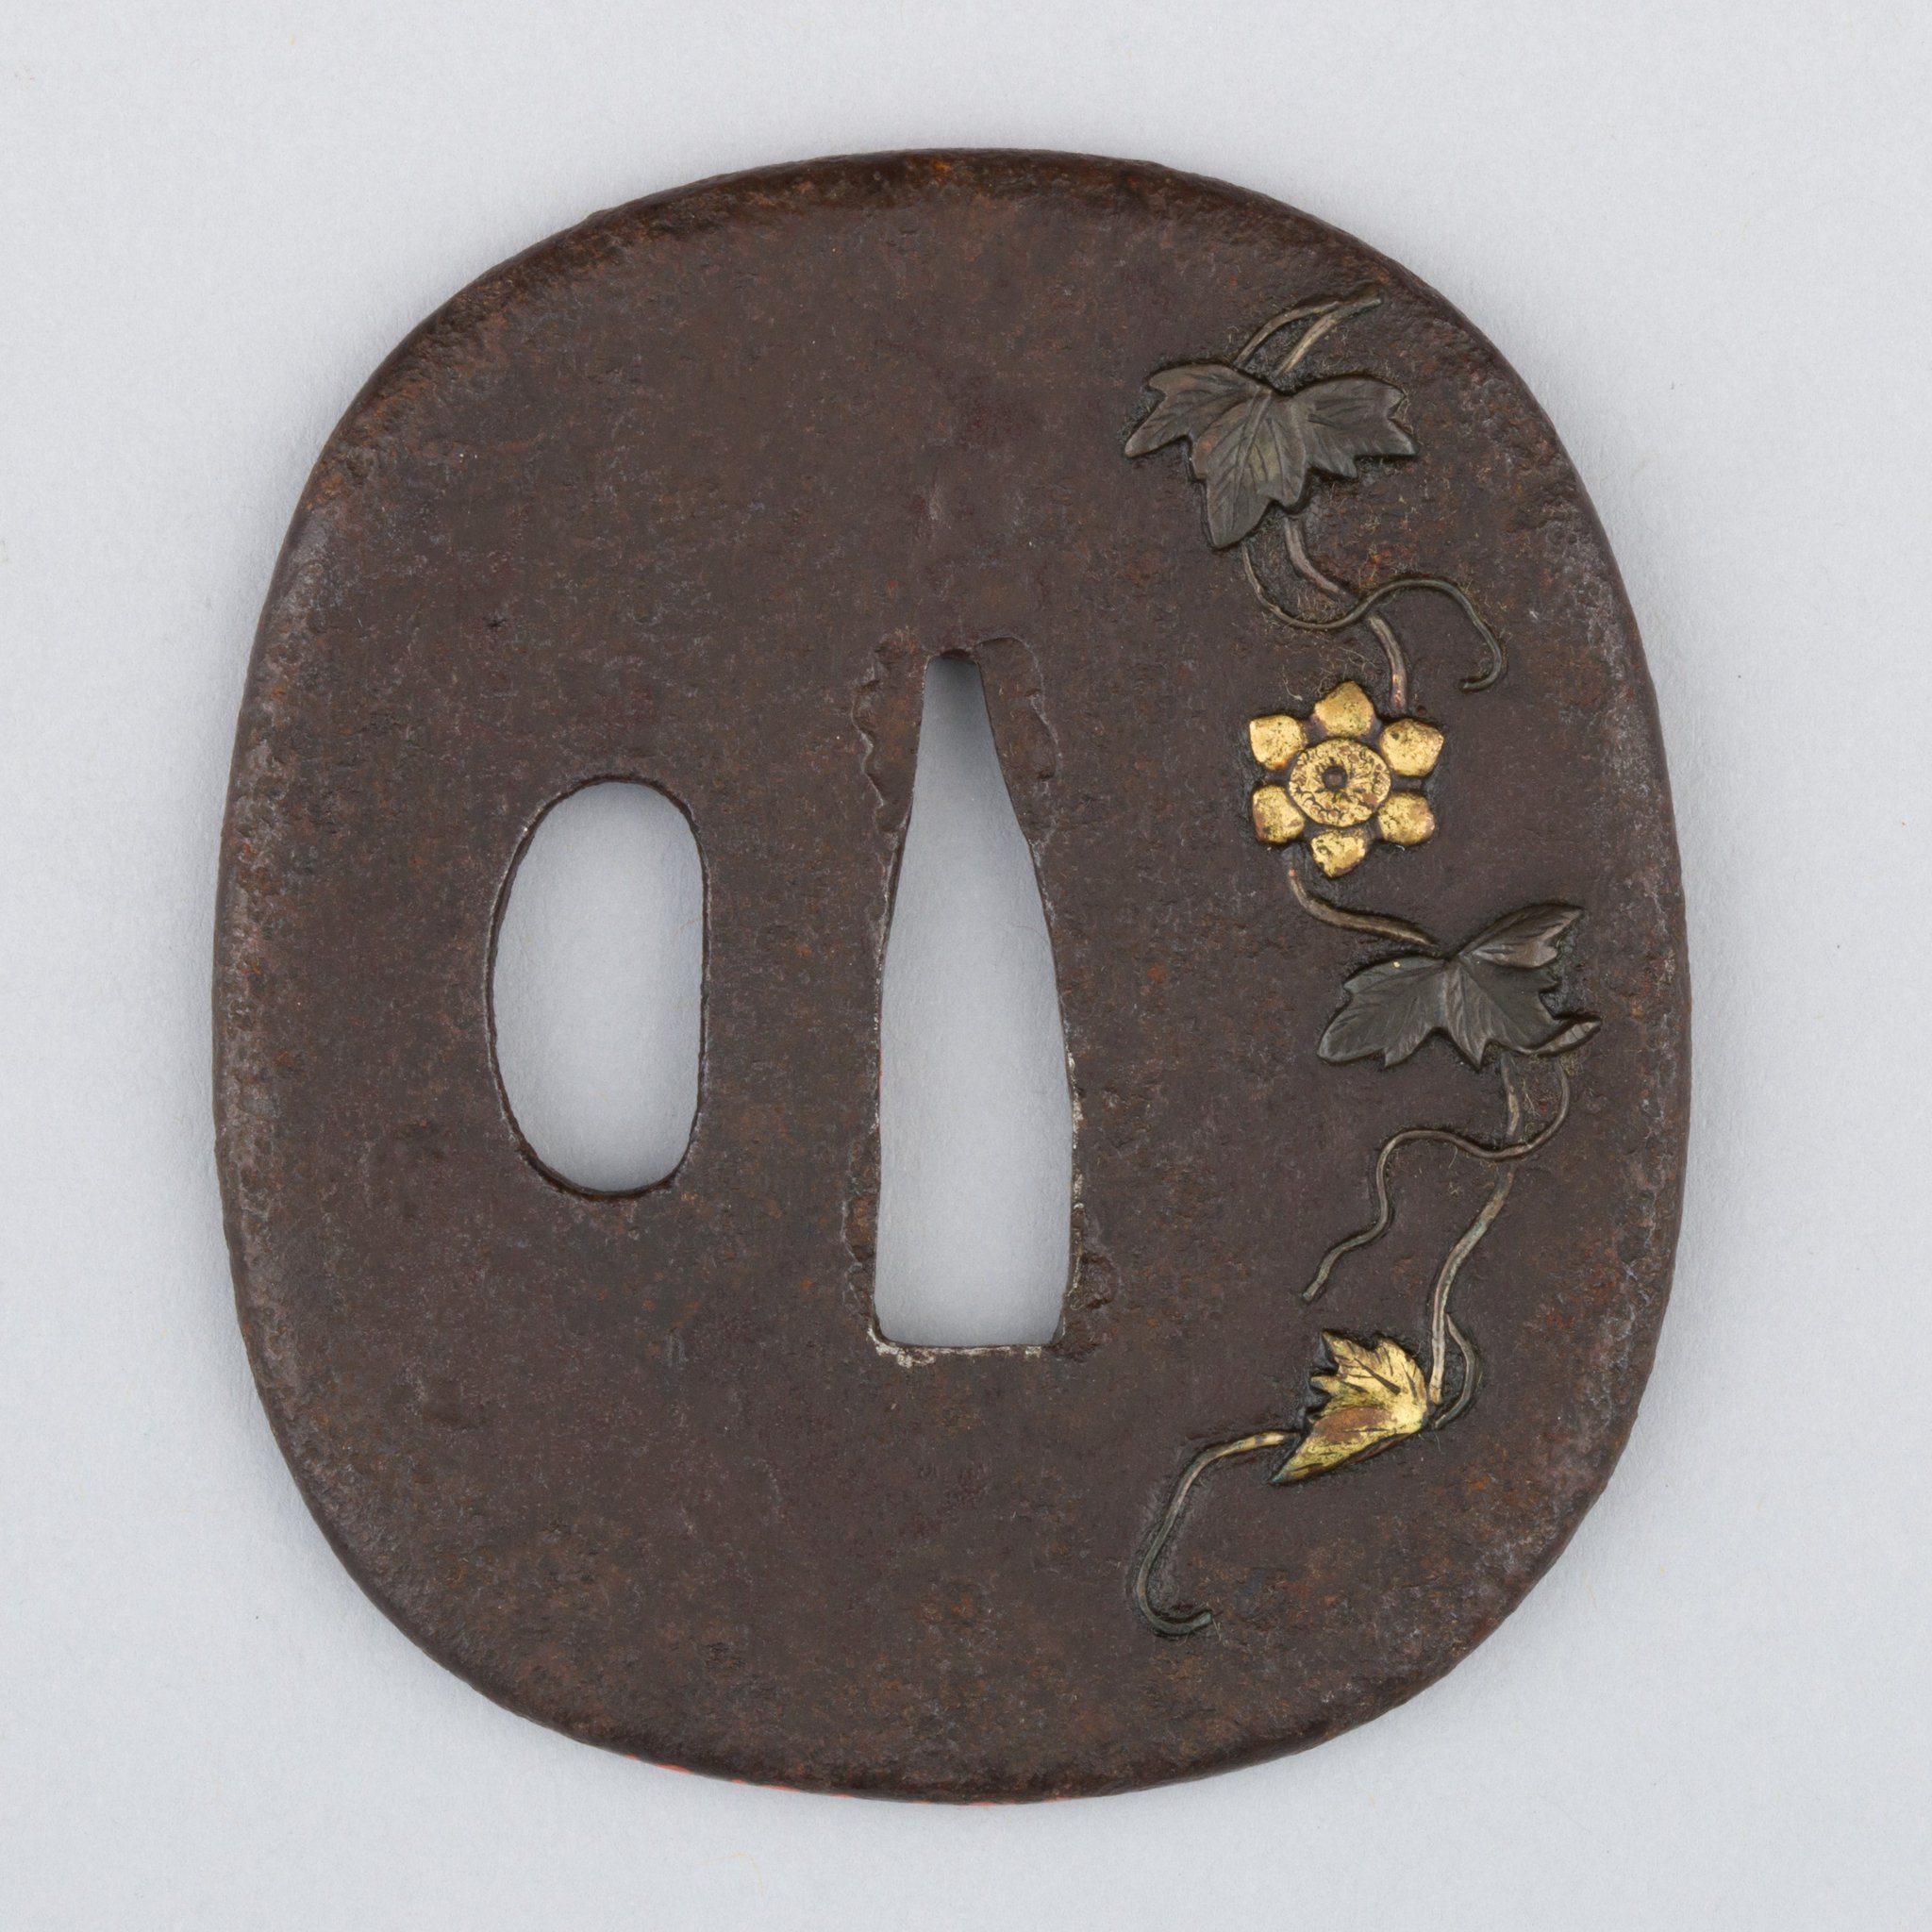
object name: sword guard tsuba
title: Sword Guard (Tsuba)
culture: japanese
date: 1615-1868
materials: copper, gold, iron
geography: japan